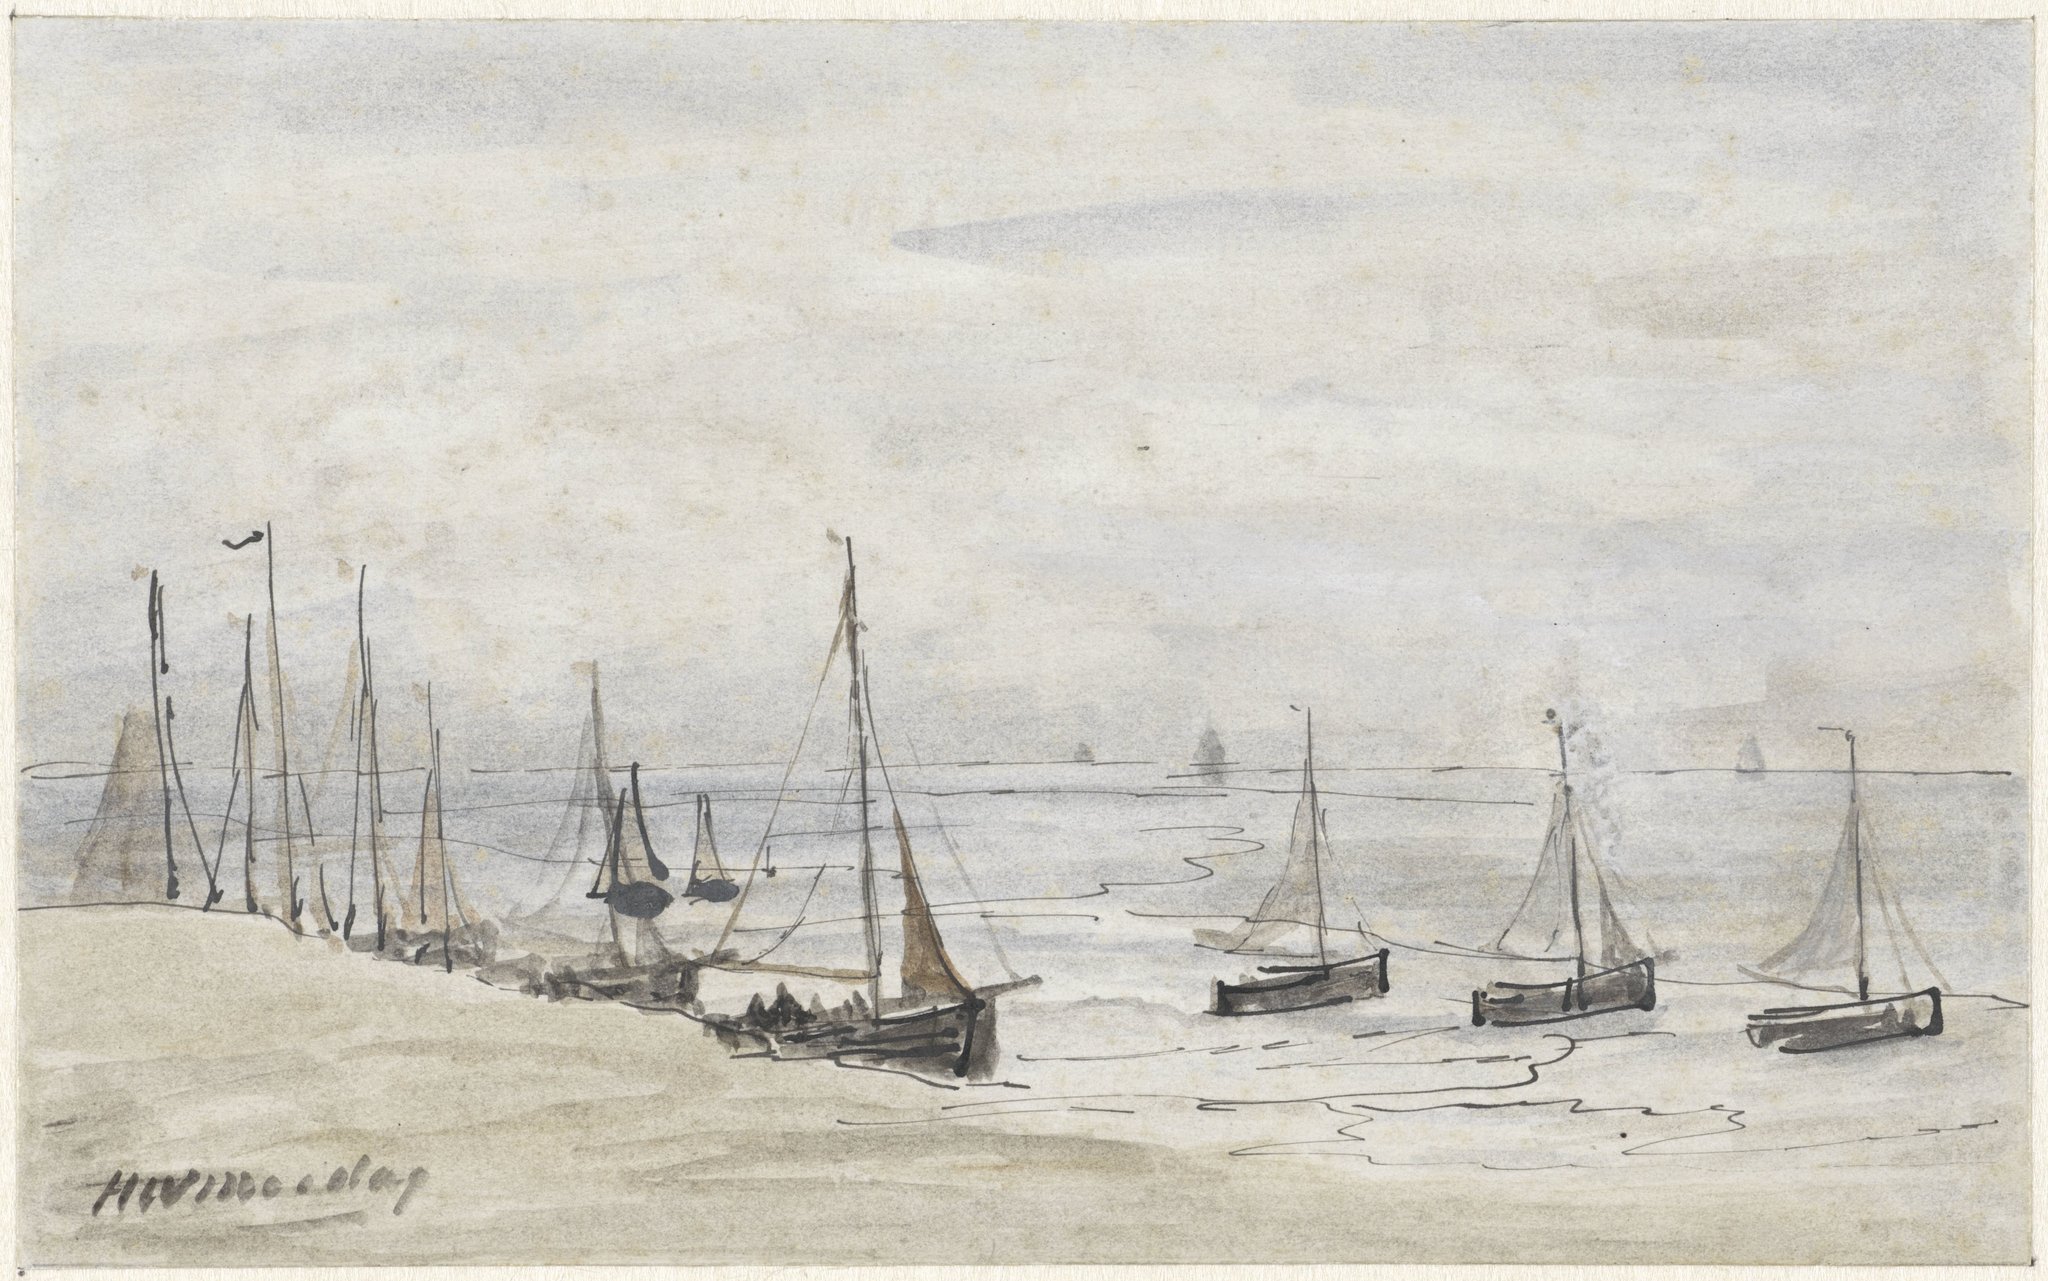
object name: drawing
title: Visserspinken op het strand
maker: hendrik willem mesdag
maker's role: draughtsman, painter, print maker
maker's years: 1831-1915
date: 1841-1915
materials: ink, paper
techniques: brush, pen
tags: sailing-ship, sailing-boat, beach